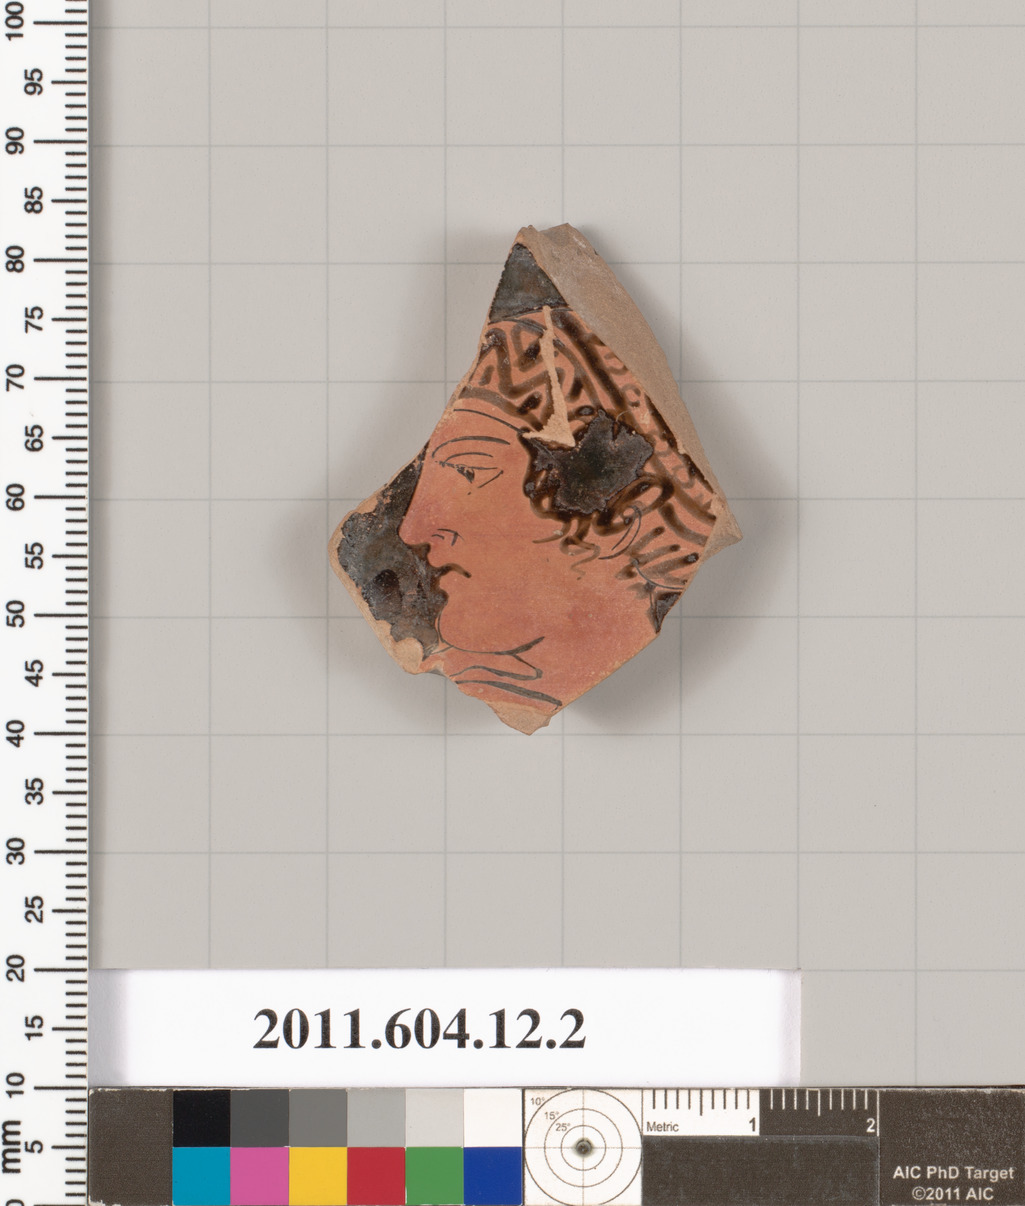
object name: krater fragment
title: Terracotta fragment of a krater (deep bowl)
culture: greek, south italian, apulian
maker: tarporley painter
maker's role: artist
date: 400-376 BCE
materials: terracotta